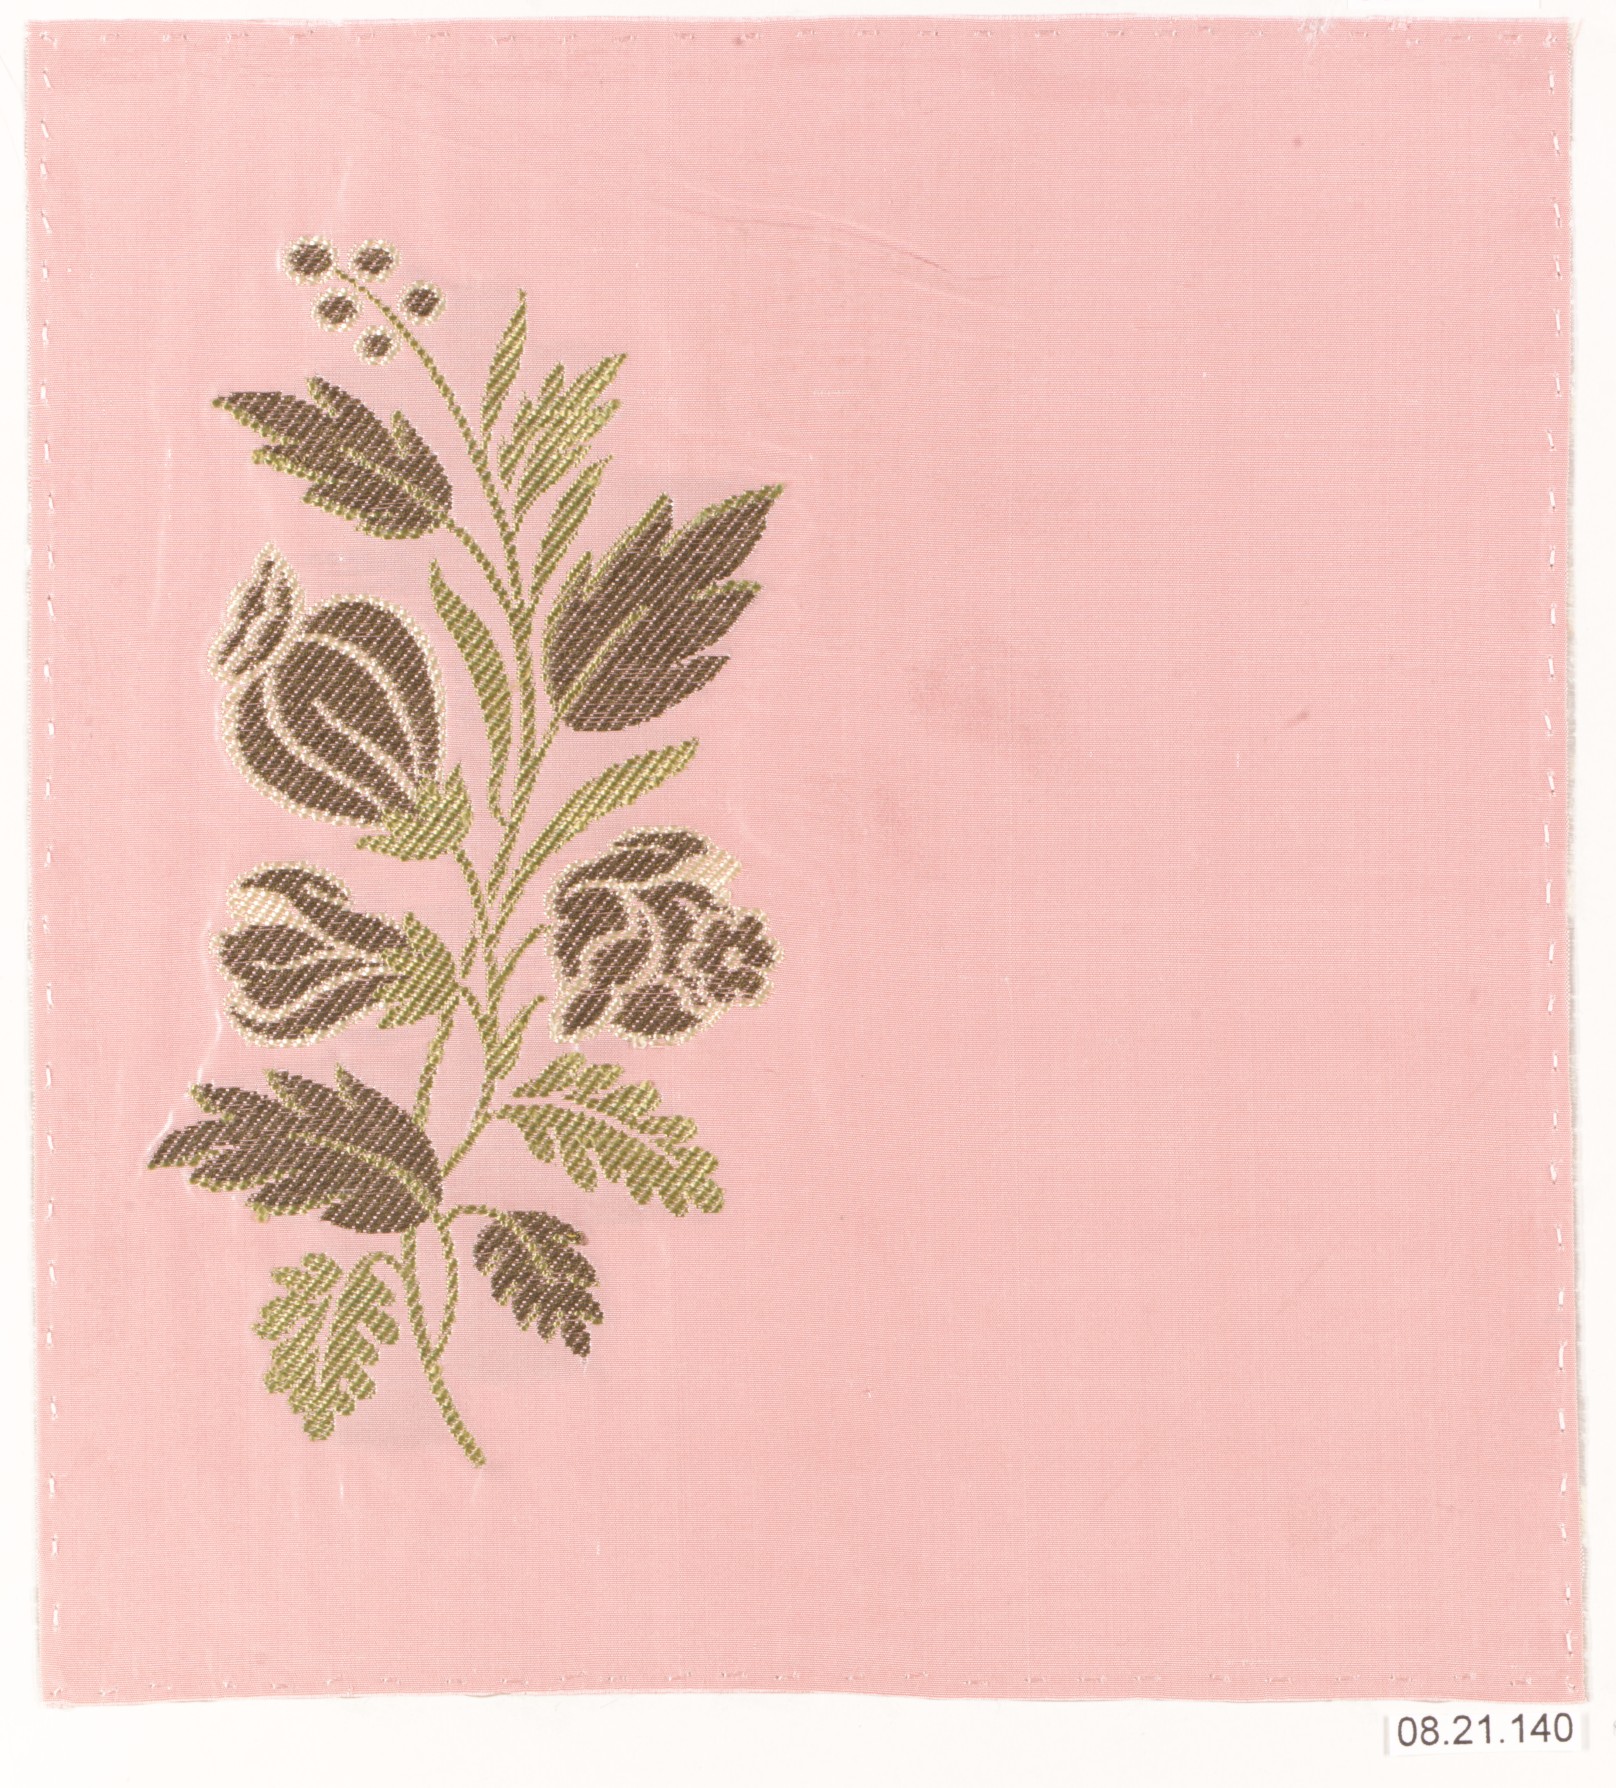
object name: textile sample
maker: Anonymous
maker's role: designer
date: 1900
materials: silk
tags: flowers,leaves